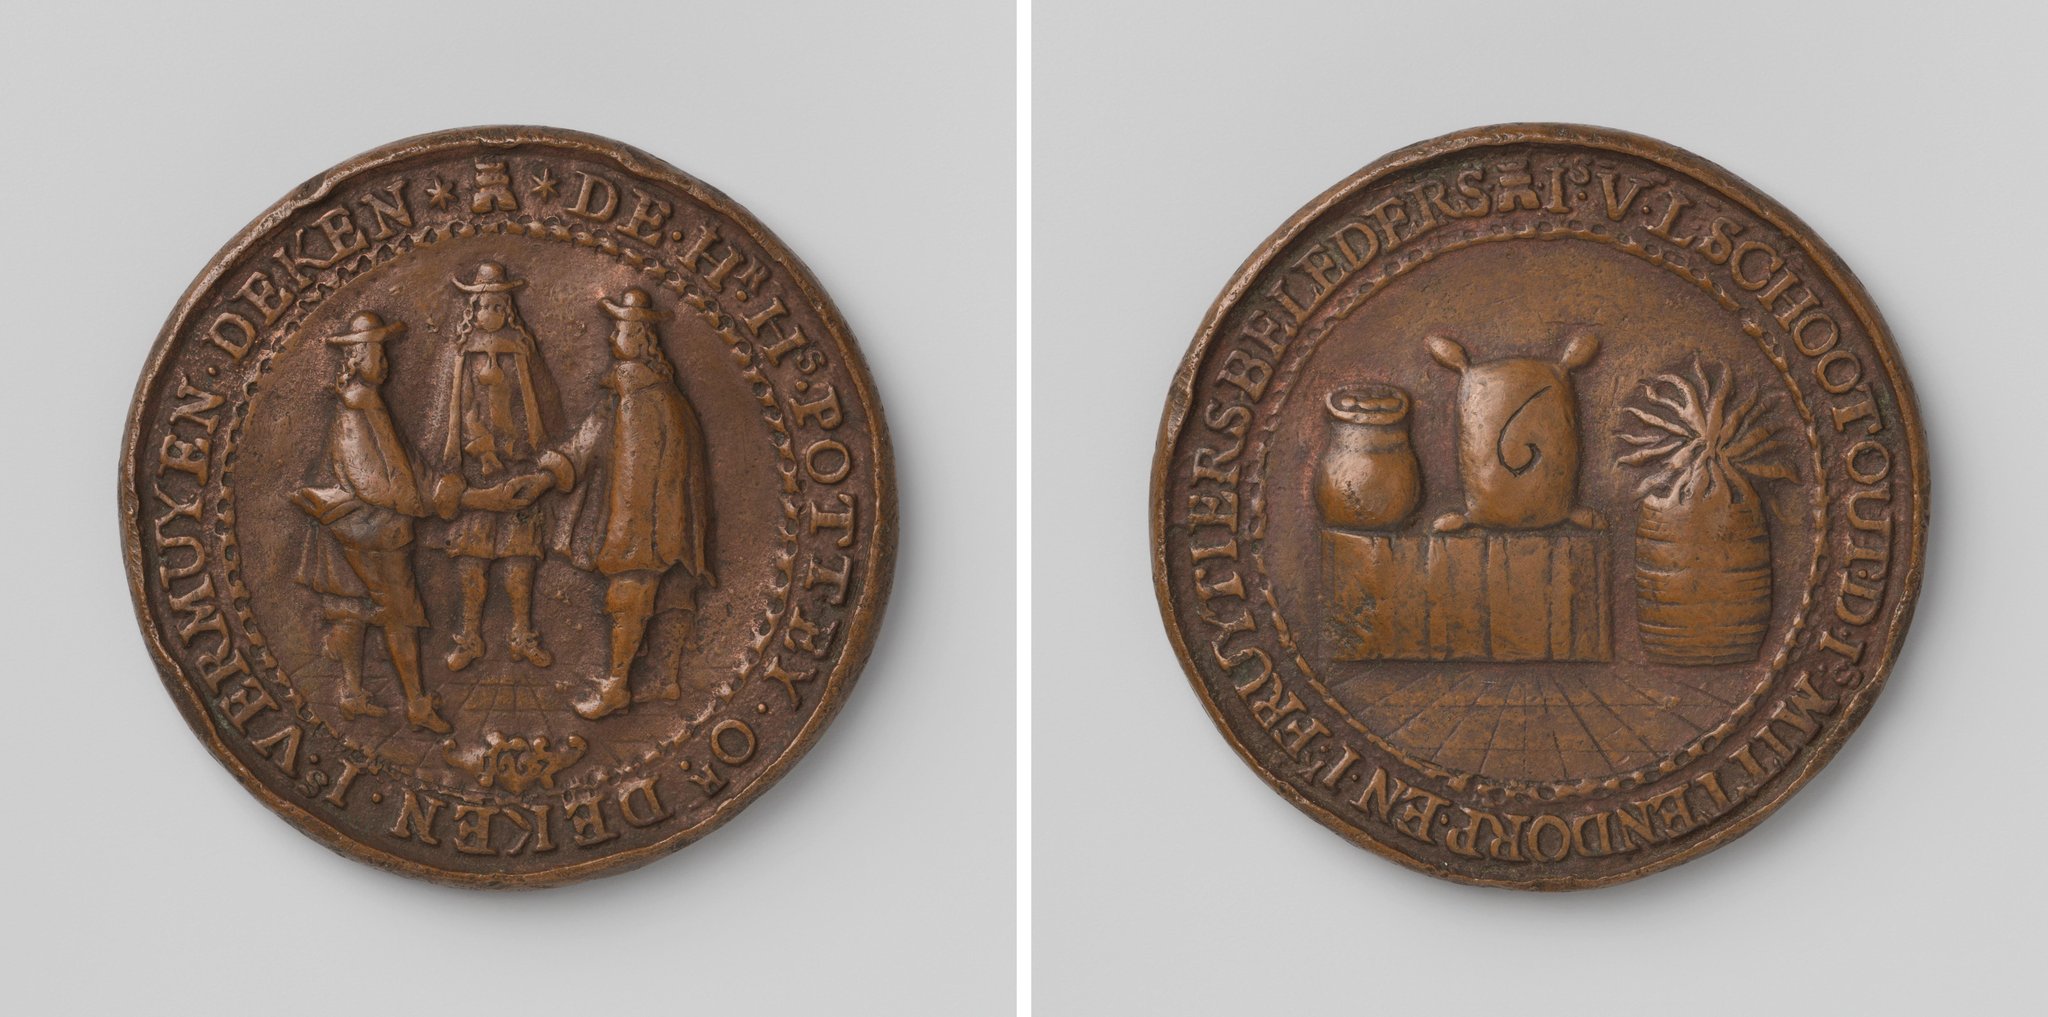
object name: medal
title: Makelaarsgilde van Middelburg, gildepenning met no. 6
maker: Anonymous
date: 1667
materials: copper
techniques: striking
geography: middelburg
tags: middelburg